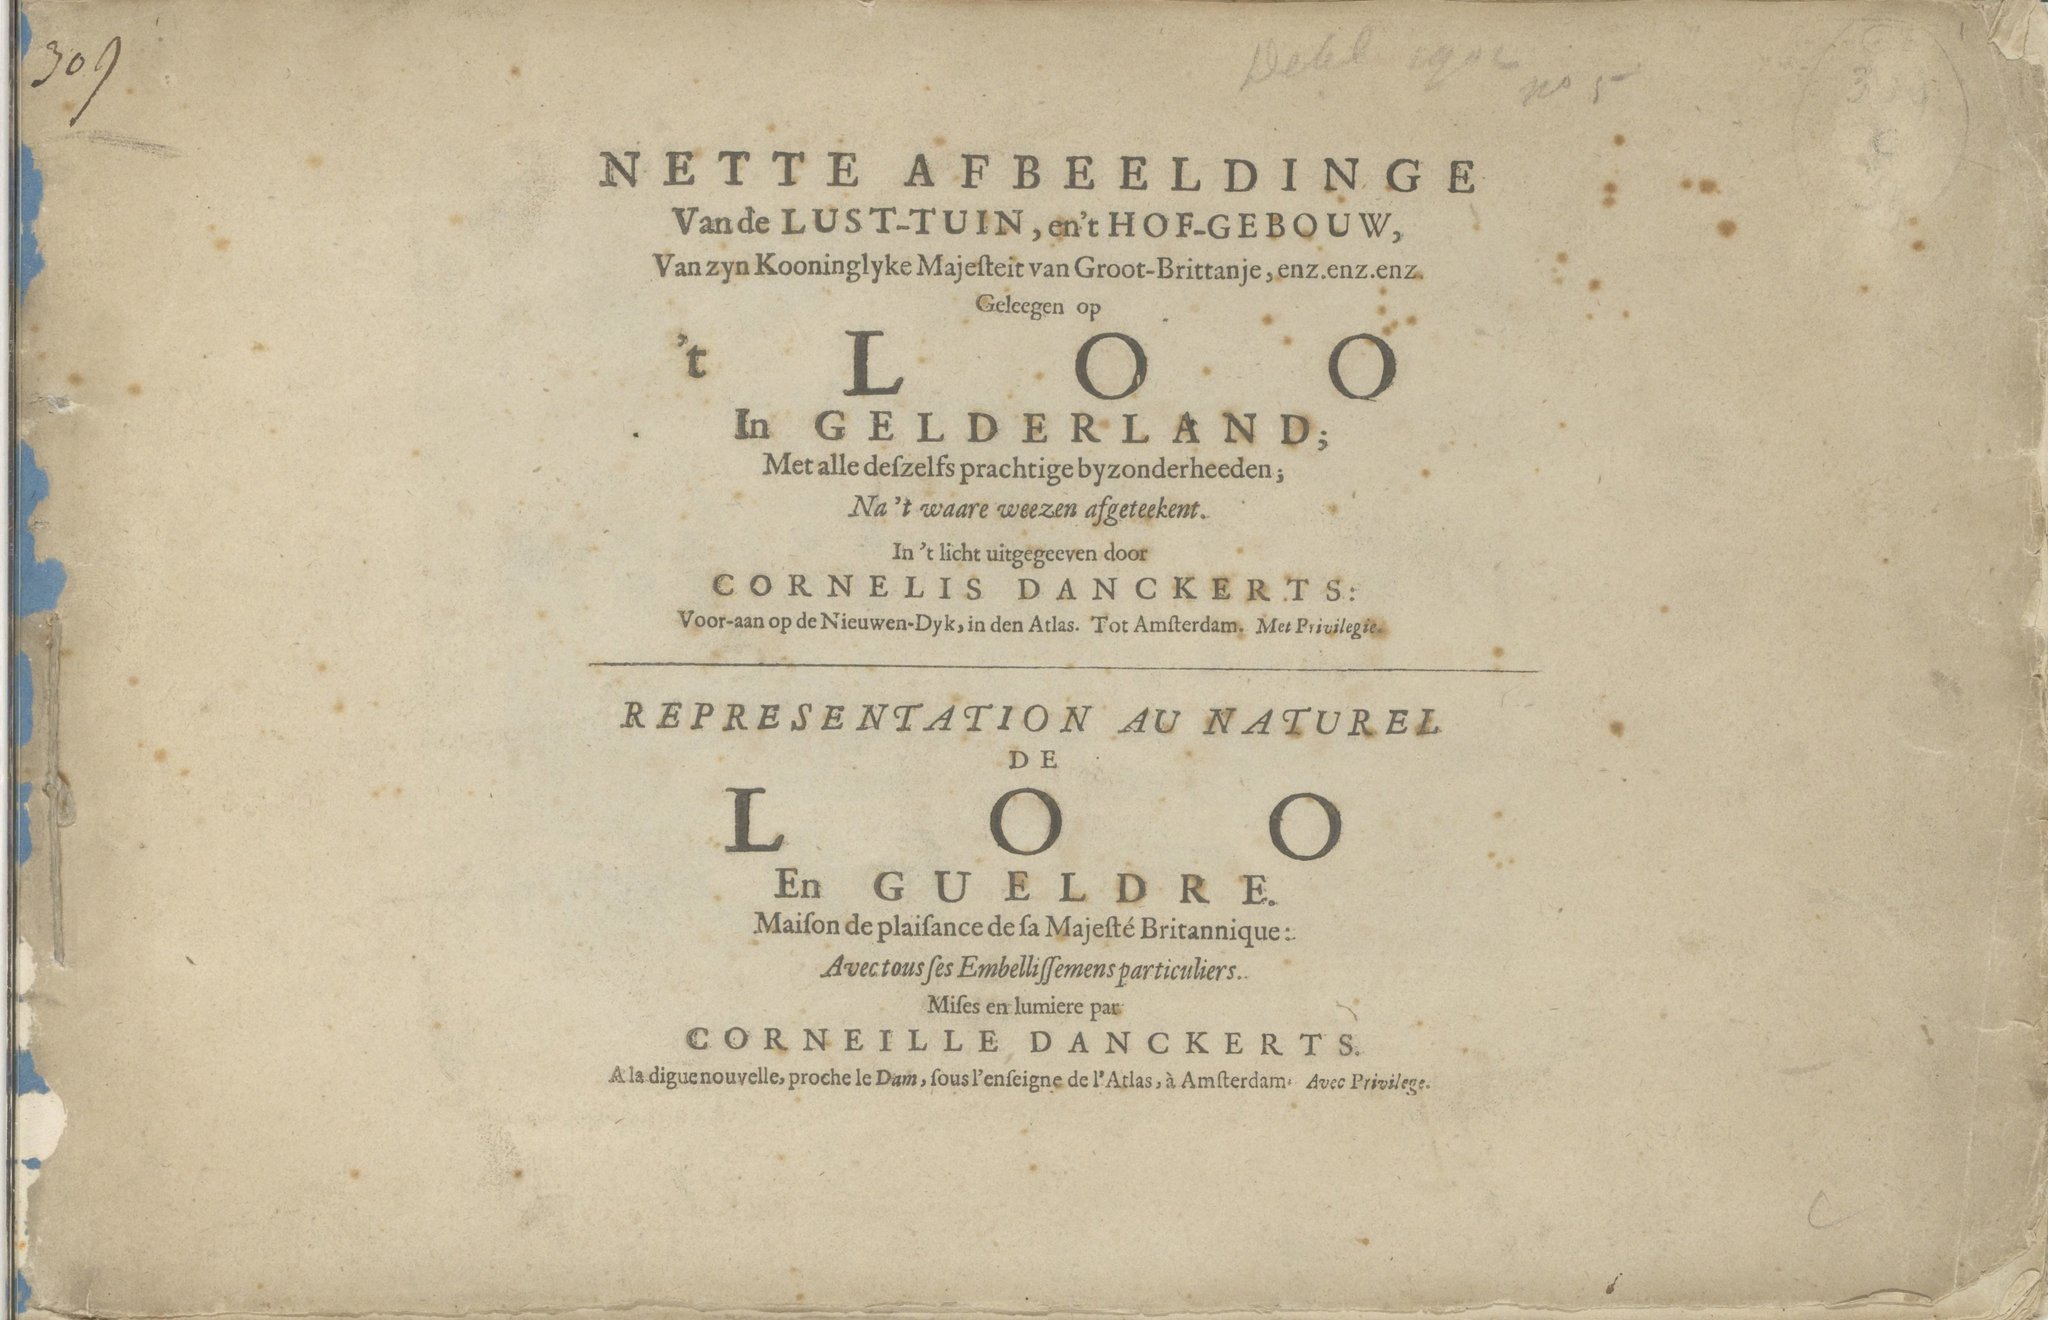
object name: titelblad, titelpagina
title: Nette Afbeeldinge Van de Lust-Tuin, en 't Hof-Gebouw, Van zyn Kooninglyke Majesteit van Groot-Brittanje, enz. enz. enz. Geleegen op 't Loo In Gelderland (...) / Representation au Naturel de Loo En Gueldre. Maison de plaisance de sa Majesté Britannique (...)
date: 1696-1718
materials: paper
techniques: letterpress printing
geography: amsterdam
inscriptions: number: ‘309’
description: Titelpagina voor een serie prenten met voorstellingen van Paleis Het Loo. Titelpagina maakt deel uit van een album.